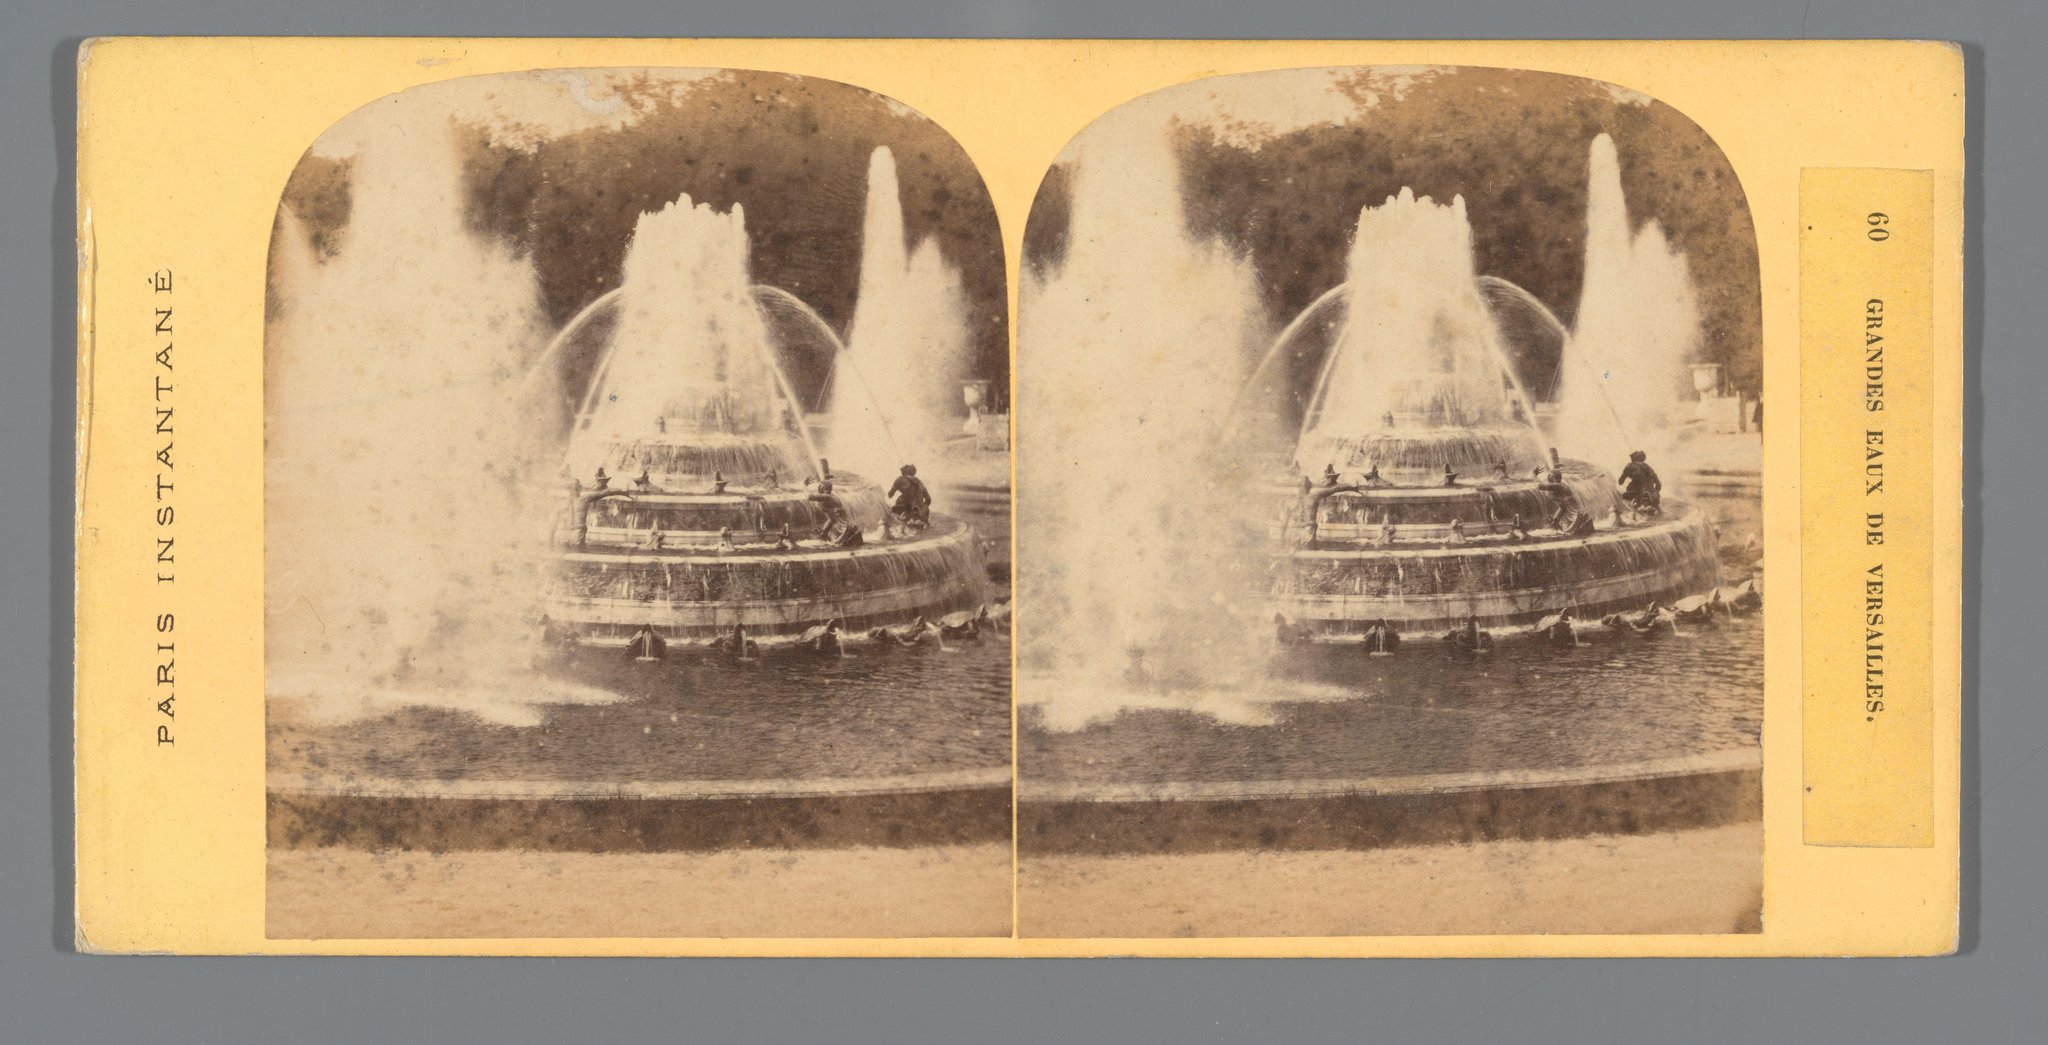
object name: stereograph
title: Grandes Eaux de Versailles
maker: Anonymous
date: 1850-1880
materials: cardboard, photographic support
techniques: albumen print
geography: versailles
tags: garden fountain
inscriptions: number: ‘60’